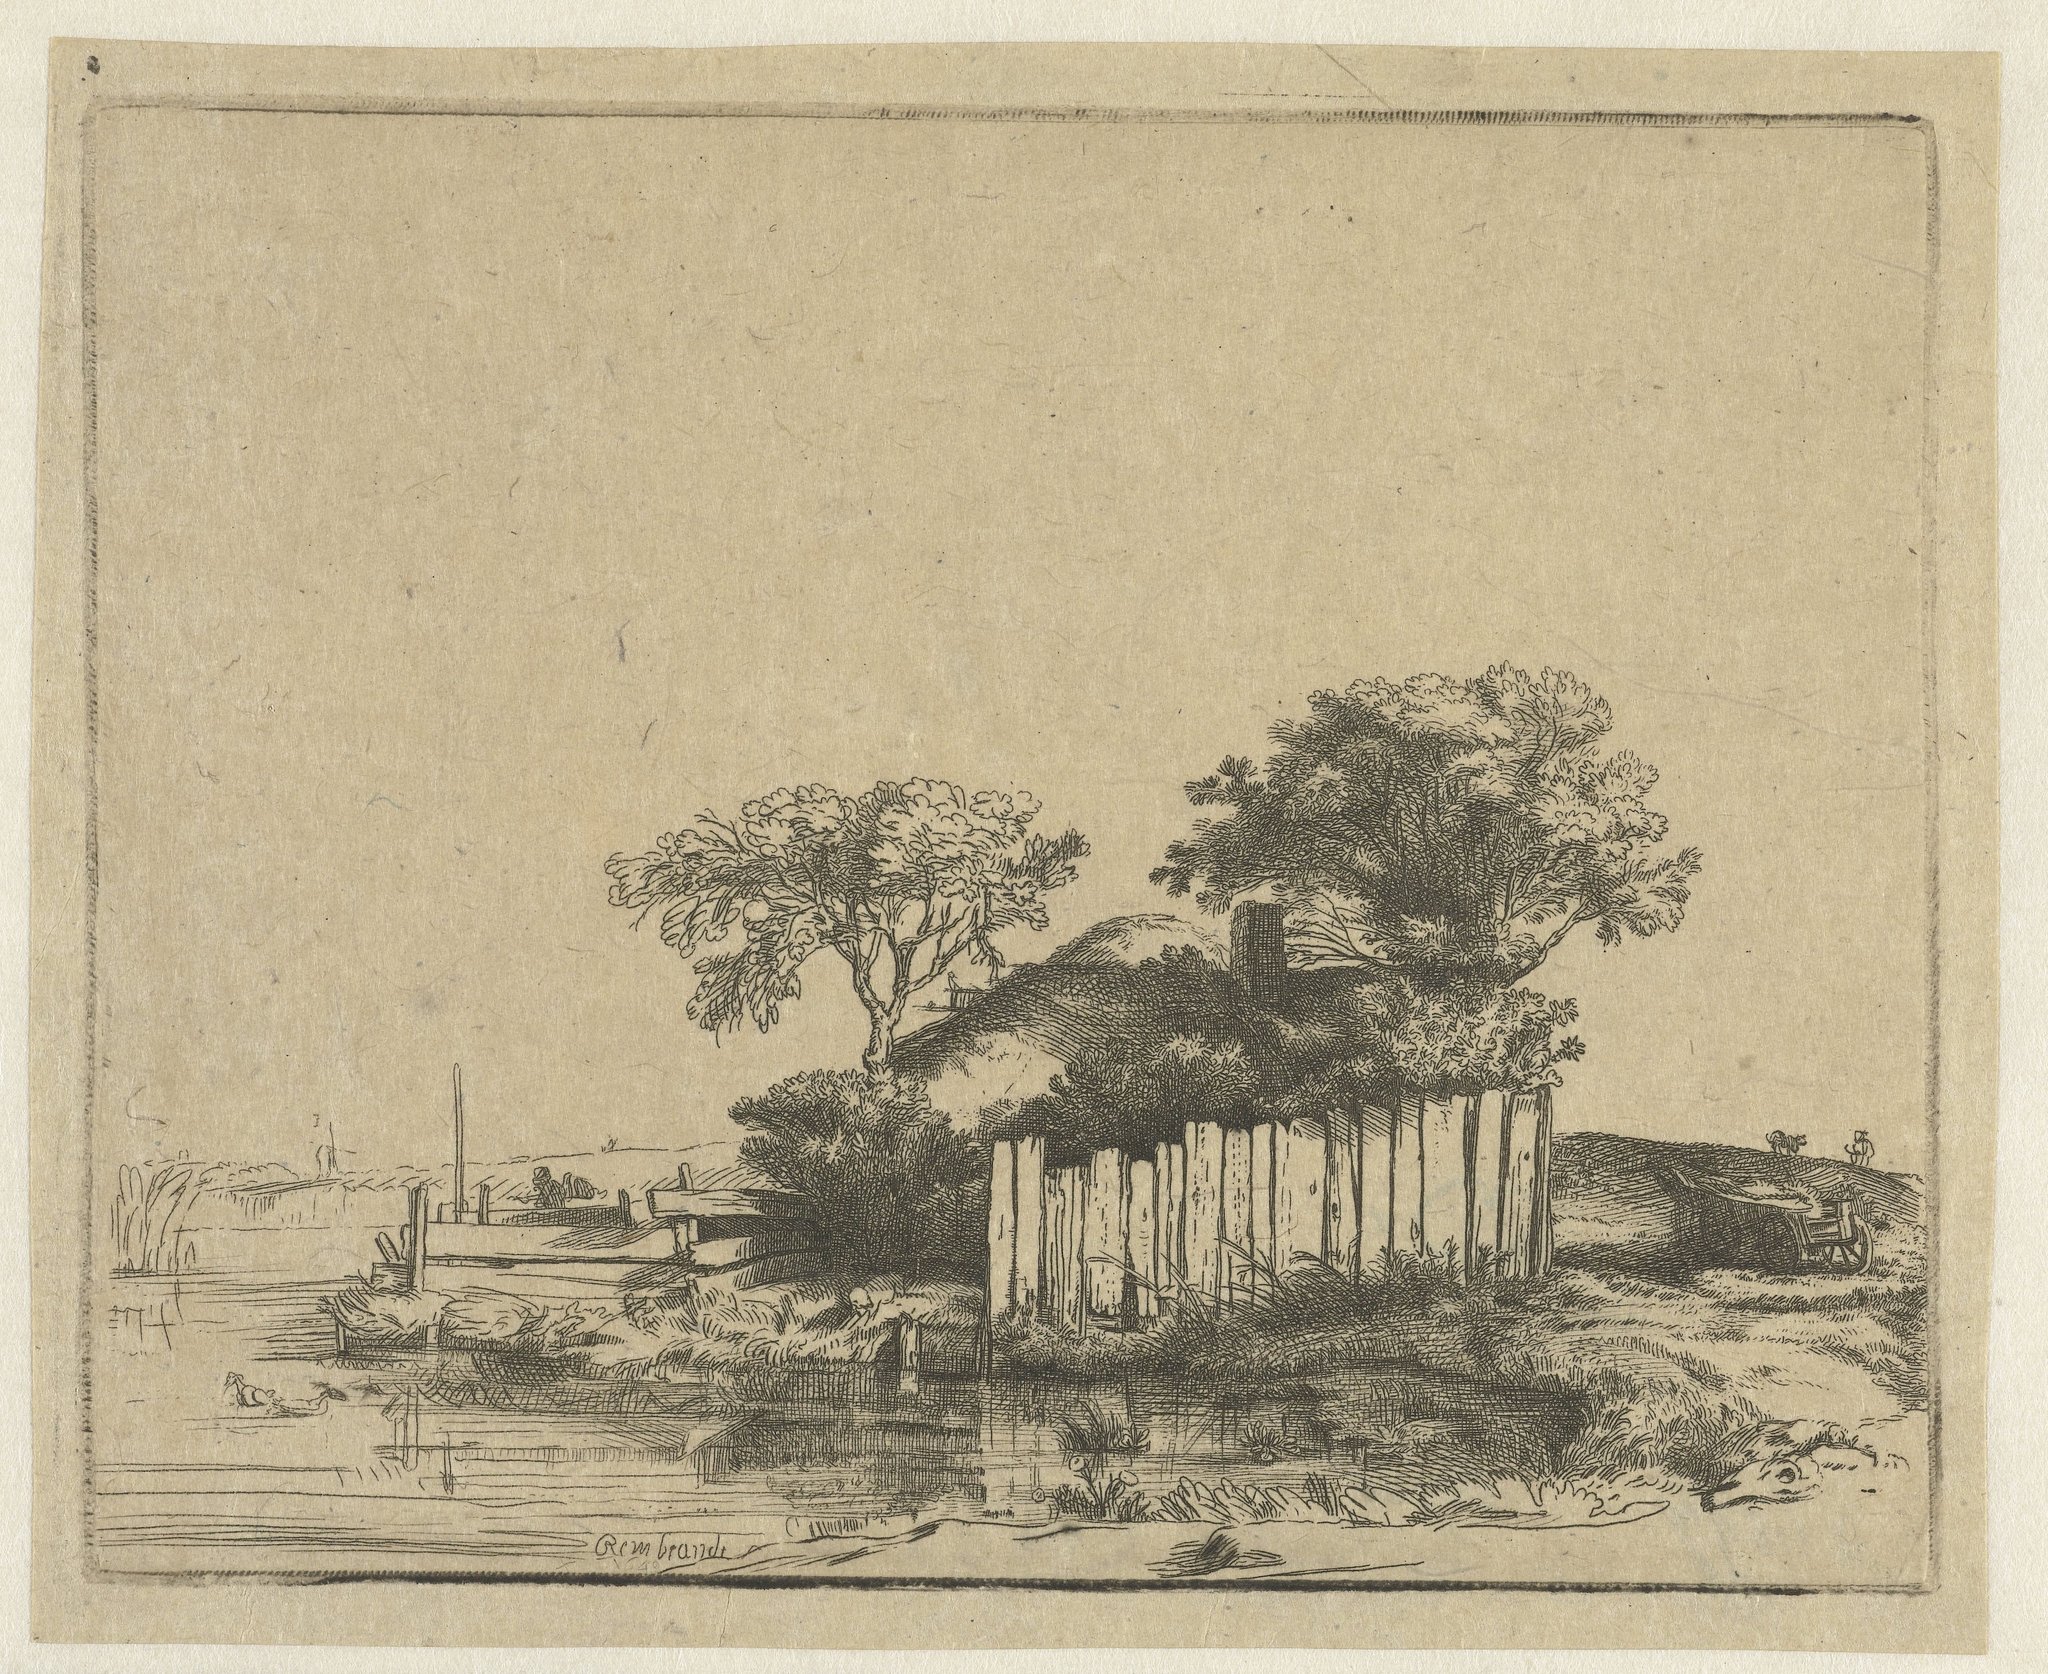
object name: print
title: Cottage with a white paling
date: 1648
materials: paper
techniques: etching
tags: monumental adornments (in city)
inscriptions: collector's mark: Lugt 2228, collector's mark: Lugt 2610